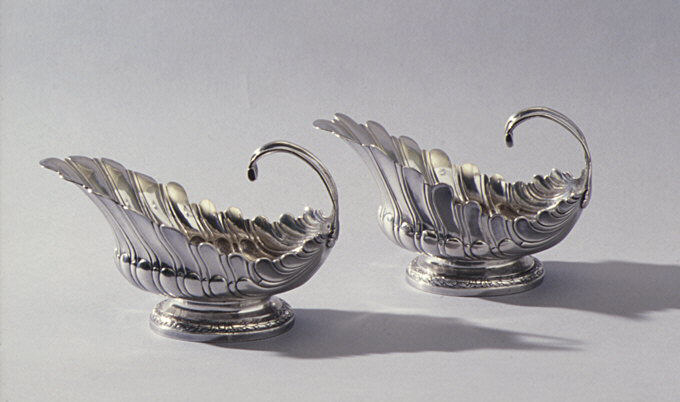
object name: sauceboat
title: Pair of sauceboats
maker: pierre-adrien dachery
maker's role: maker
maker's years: 1735-1814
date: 1768-1775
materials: silver